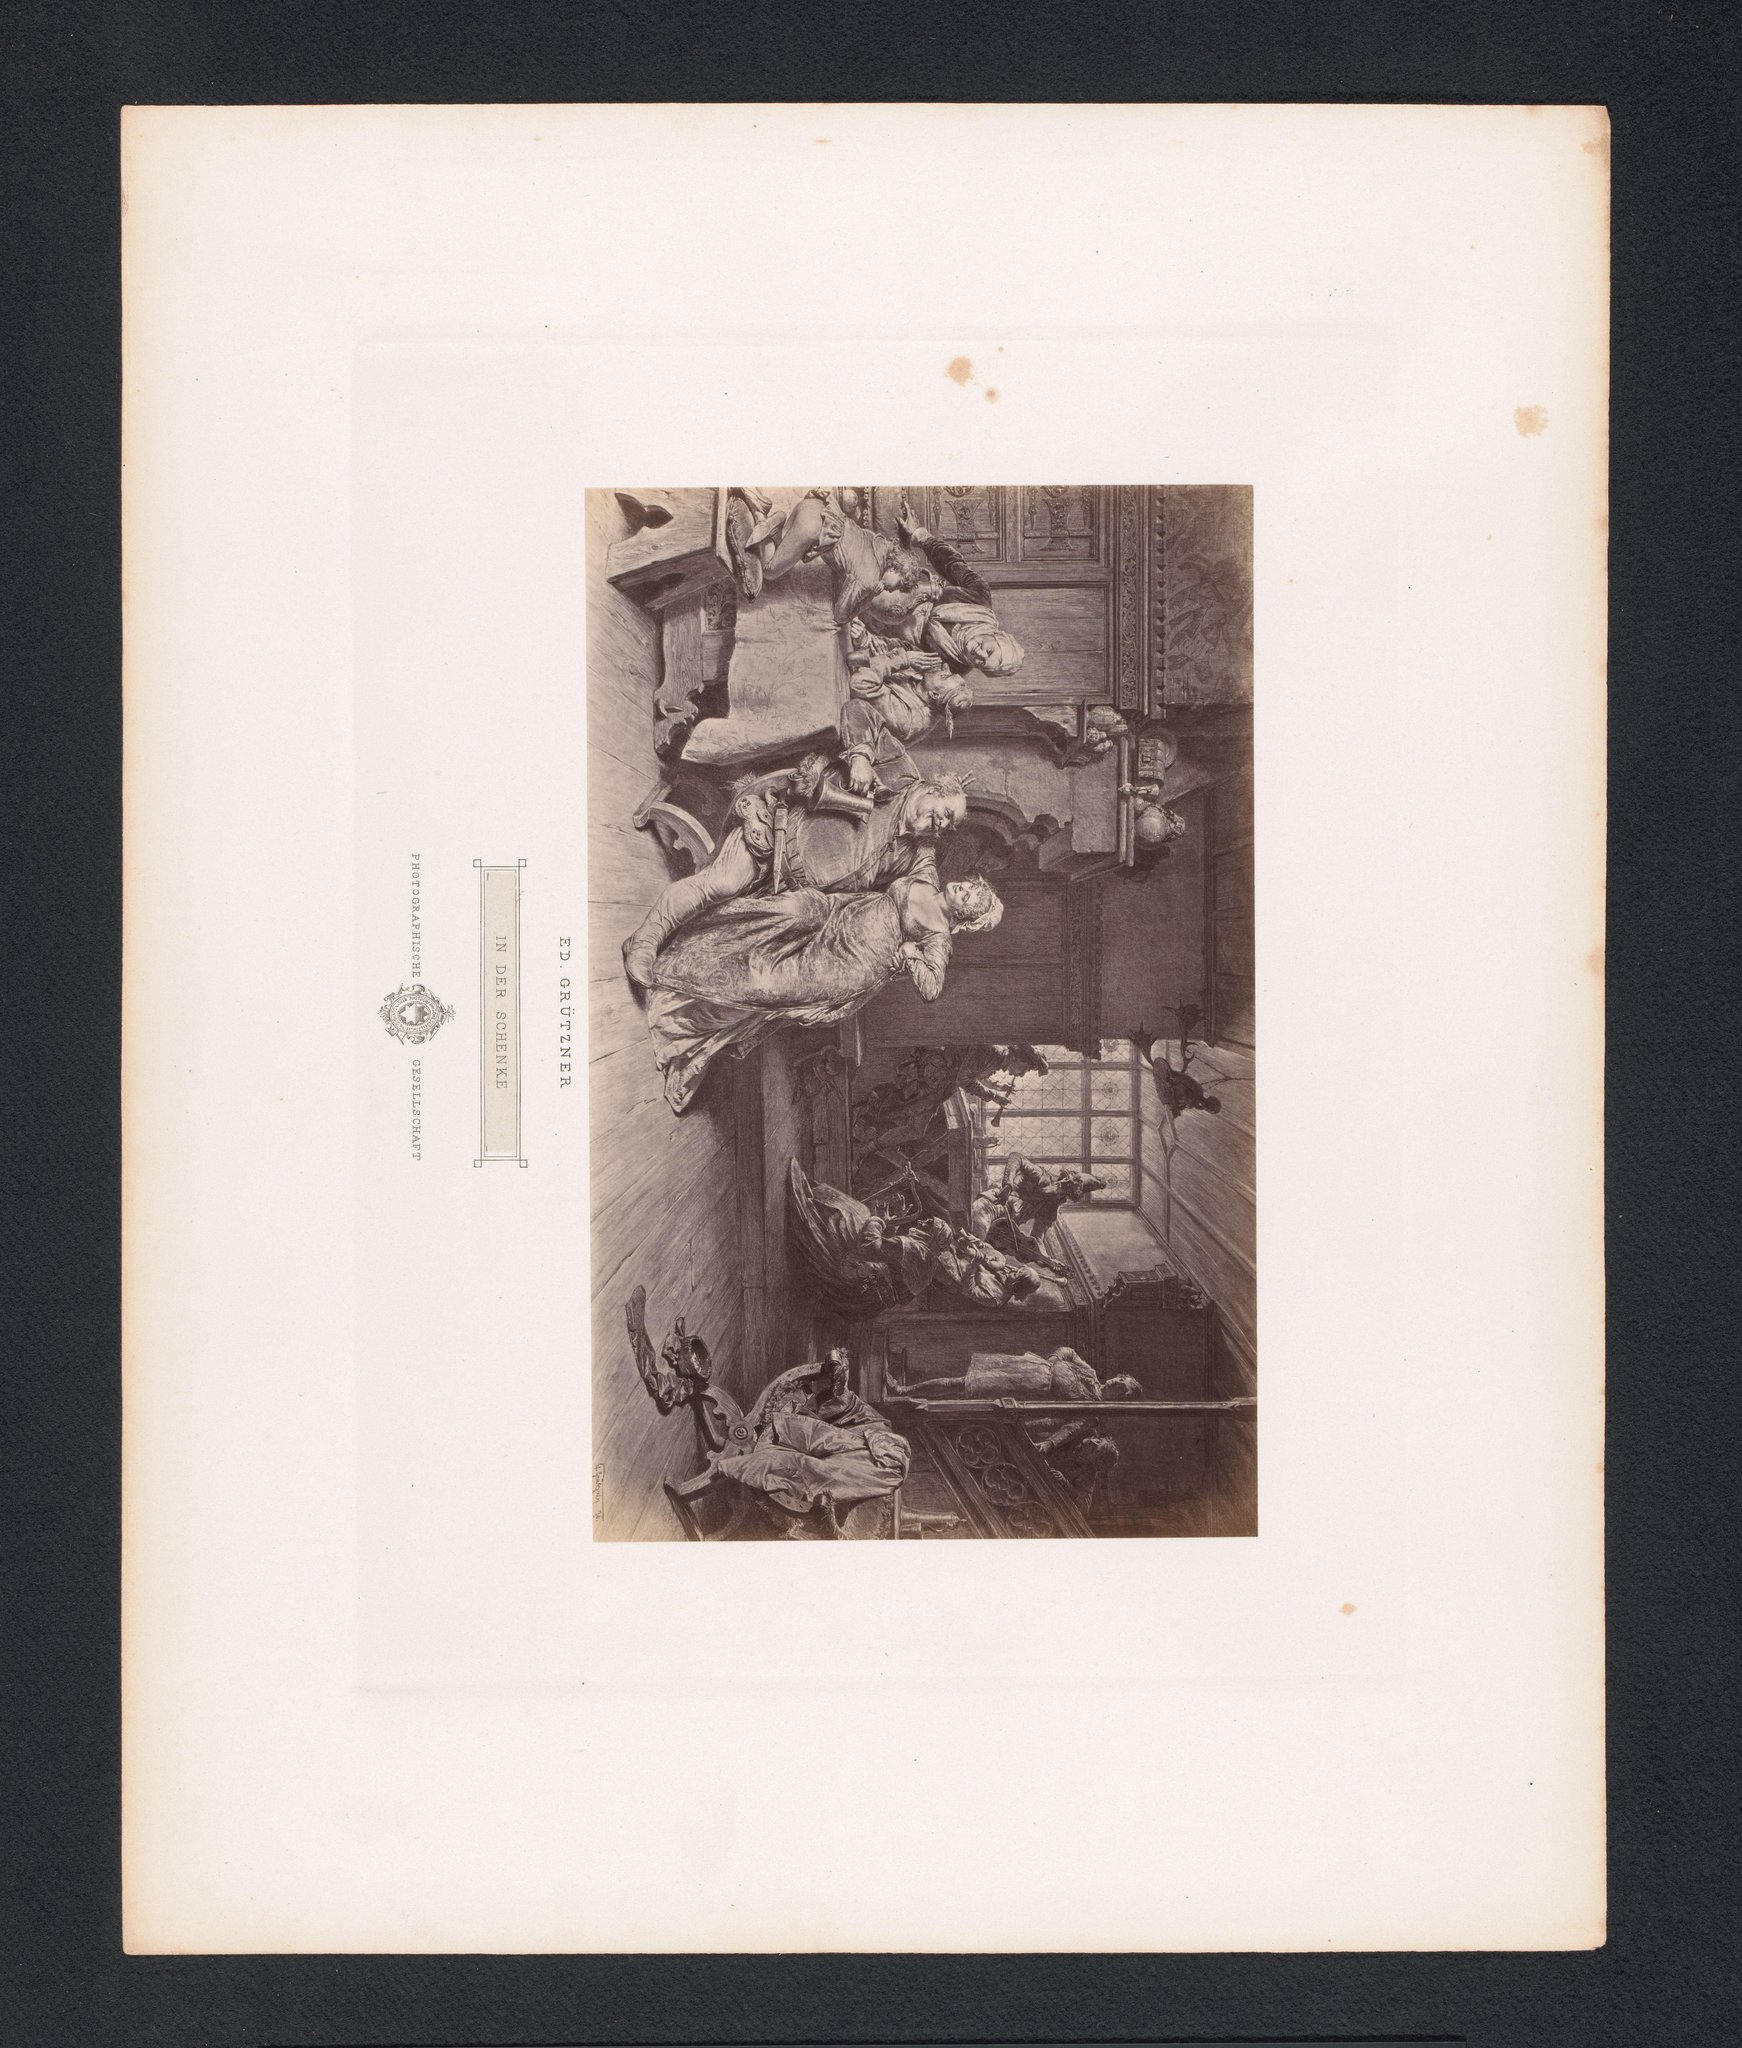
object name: photograph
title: In der Schenke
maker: eduard von grützner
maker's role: painter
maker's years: 1846-1925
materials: photographic support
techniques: albumen print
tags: inn, coffee-house, public house, etc., specific works of literature, falstaff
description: Deze foto maakt deel uit van een omslag met zeven foto's, een titelblad met foto en een tekstblad.